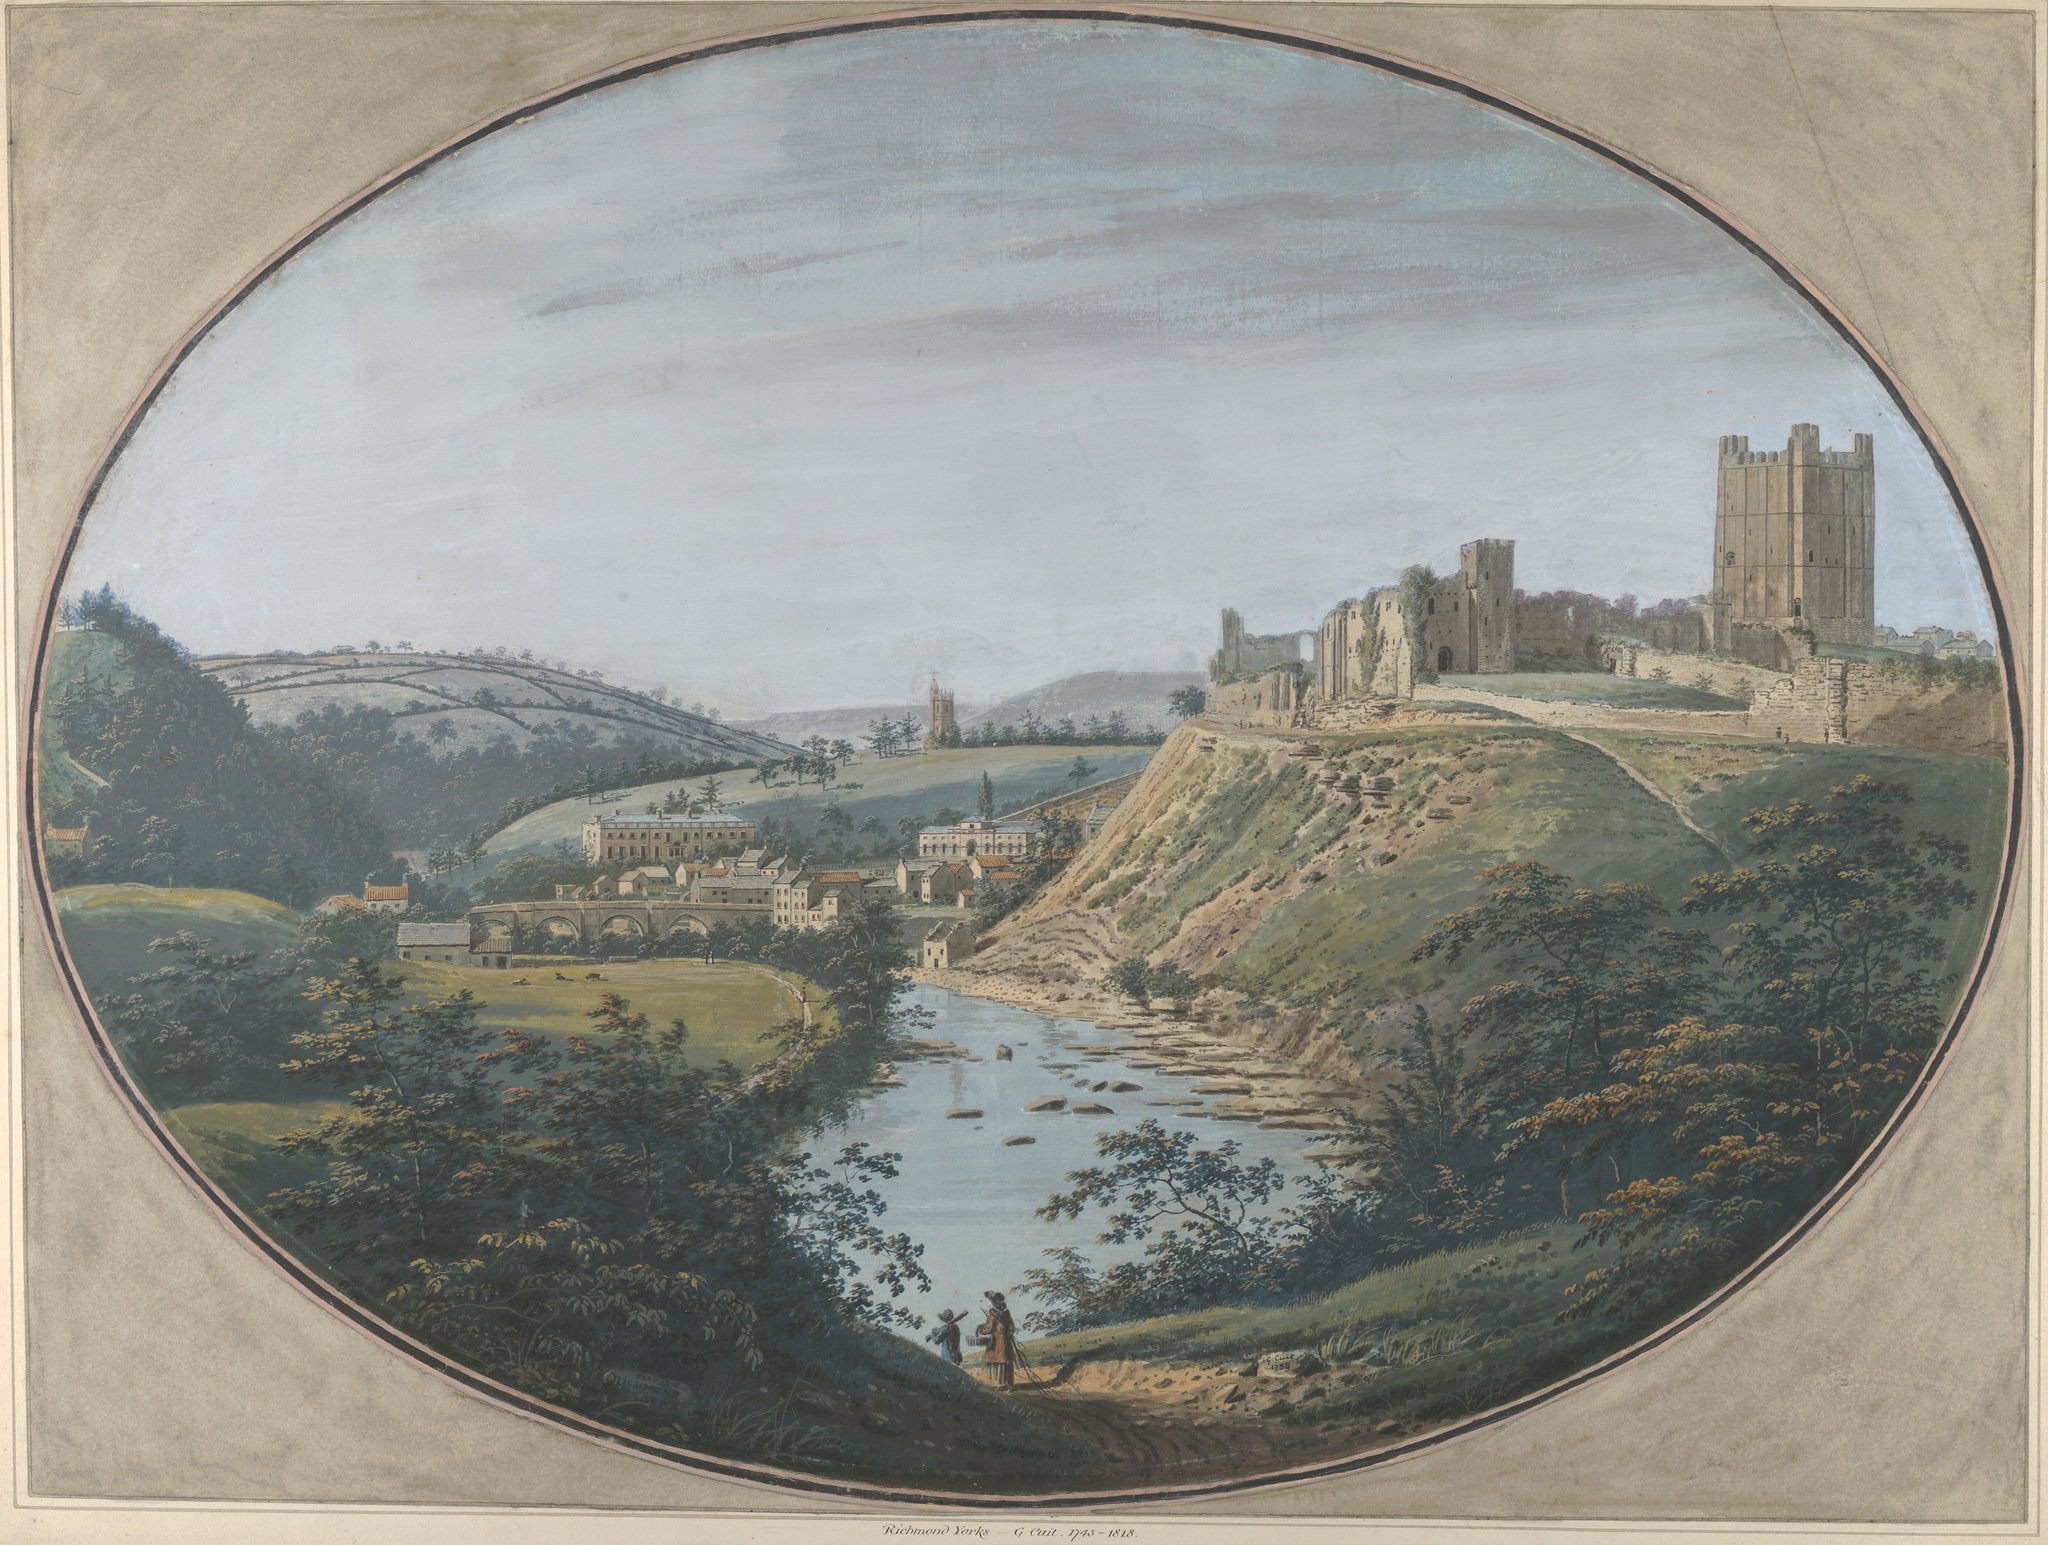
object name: drawing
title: View of Richmond, Yorkshire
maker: george cuit the elder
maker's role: artist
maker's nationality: british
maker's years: 1743-1818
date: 1788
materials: gouache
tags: rivers,landscapes